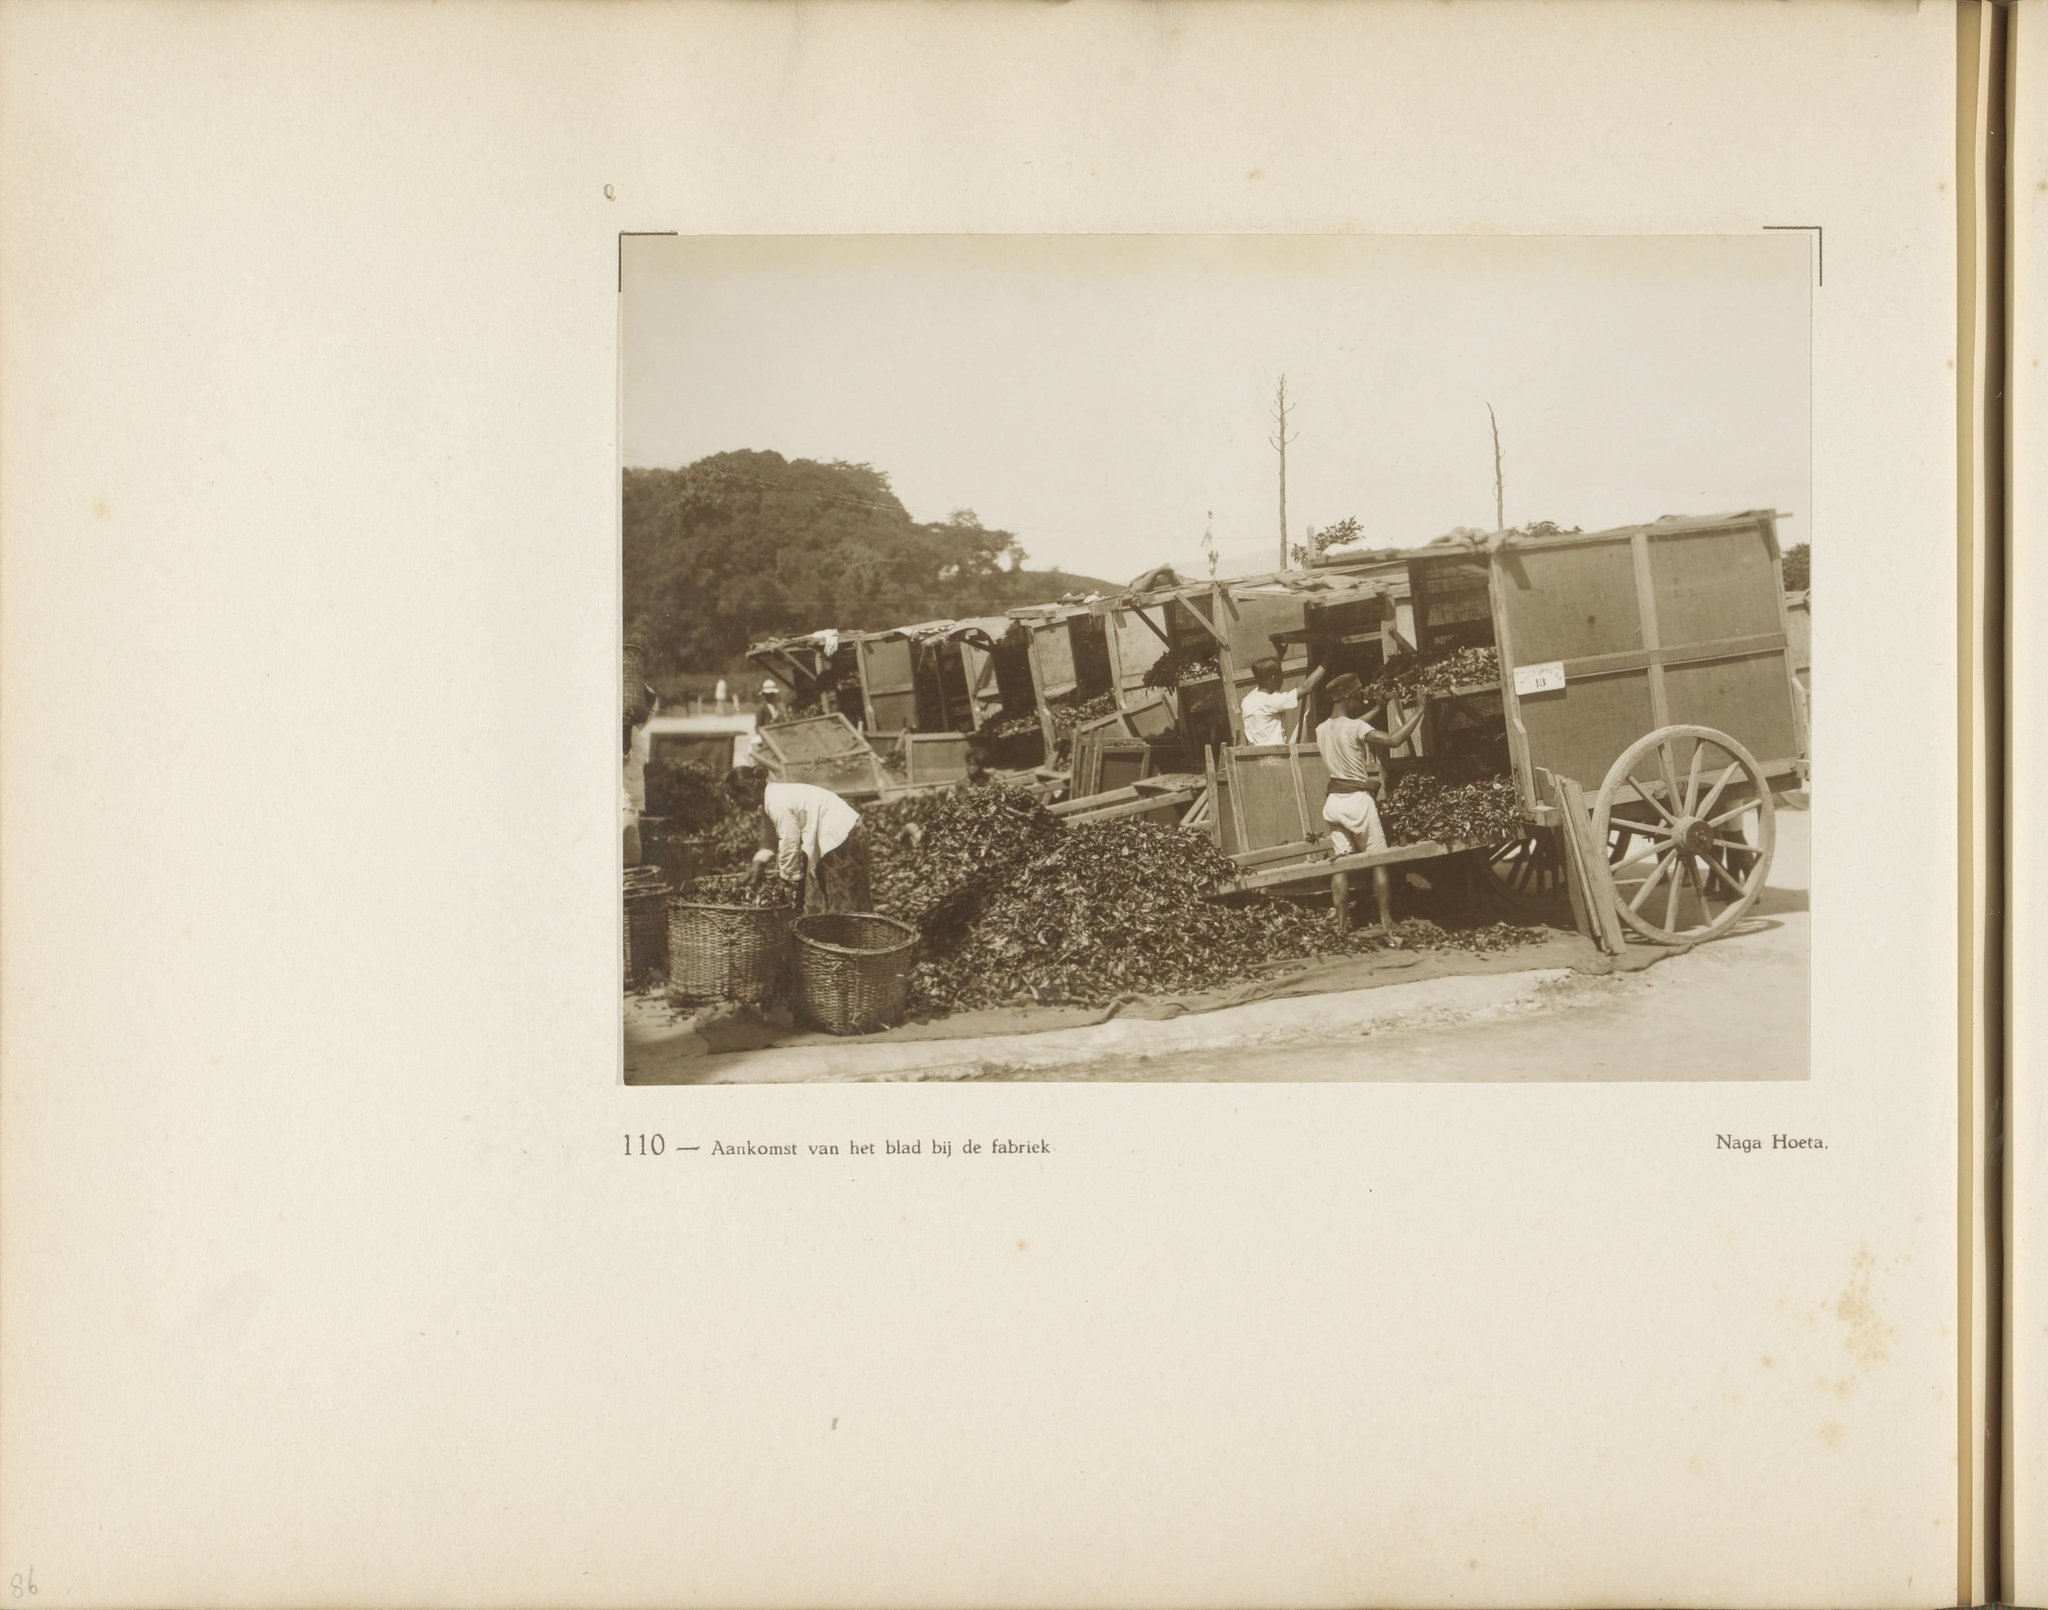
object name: album leaf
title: Pagina 110 van fotoboek van de Algemeene Vereeniging van Rubberplanters ter Oostkust van Sumatra (A.V.R.O.S.)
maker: j.w. meyster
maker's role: fotograaf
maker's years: 1887-1945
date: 1924-1925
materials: paper, photographic support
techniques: printing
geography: dutch east indies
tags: (non-fruit) products of plants or trees: rubber, cultivation ~ agriculture (+ men (labourers)), two-wheeled, animal-drawn vehicle, tea (leaves), sumatra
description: Boekpagina met een foto van het lossen van met theebladeren gevulde paardenkarren bij een fabriek te Naga Hoeta. Onderdeel van een fotoboek van de Algemeene Vereeniging van Rubberplanters ter Oostkust van Sumatra (A.V.R.O.S.).